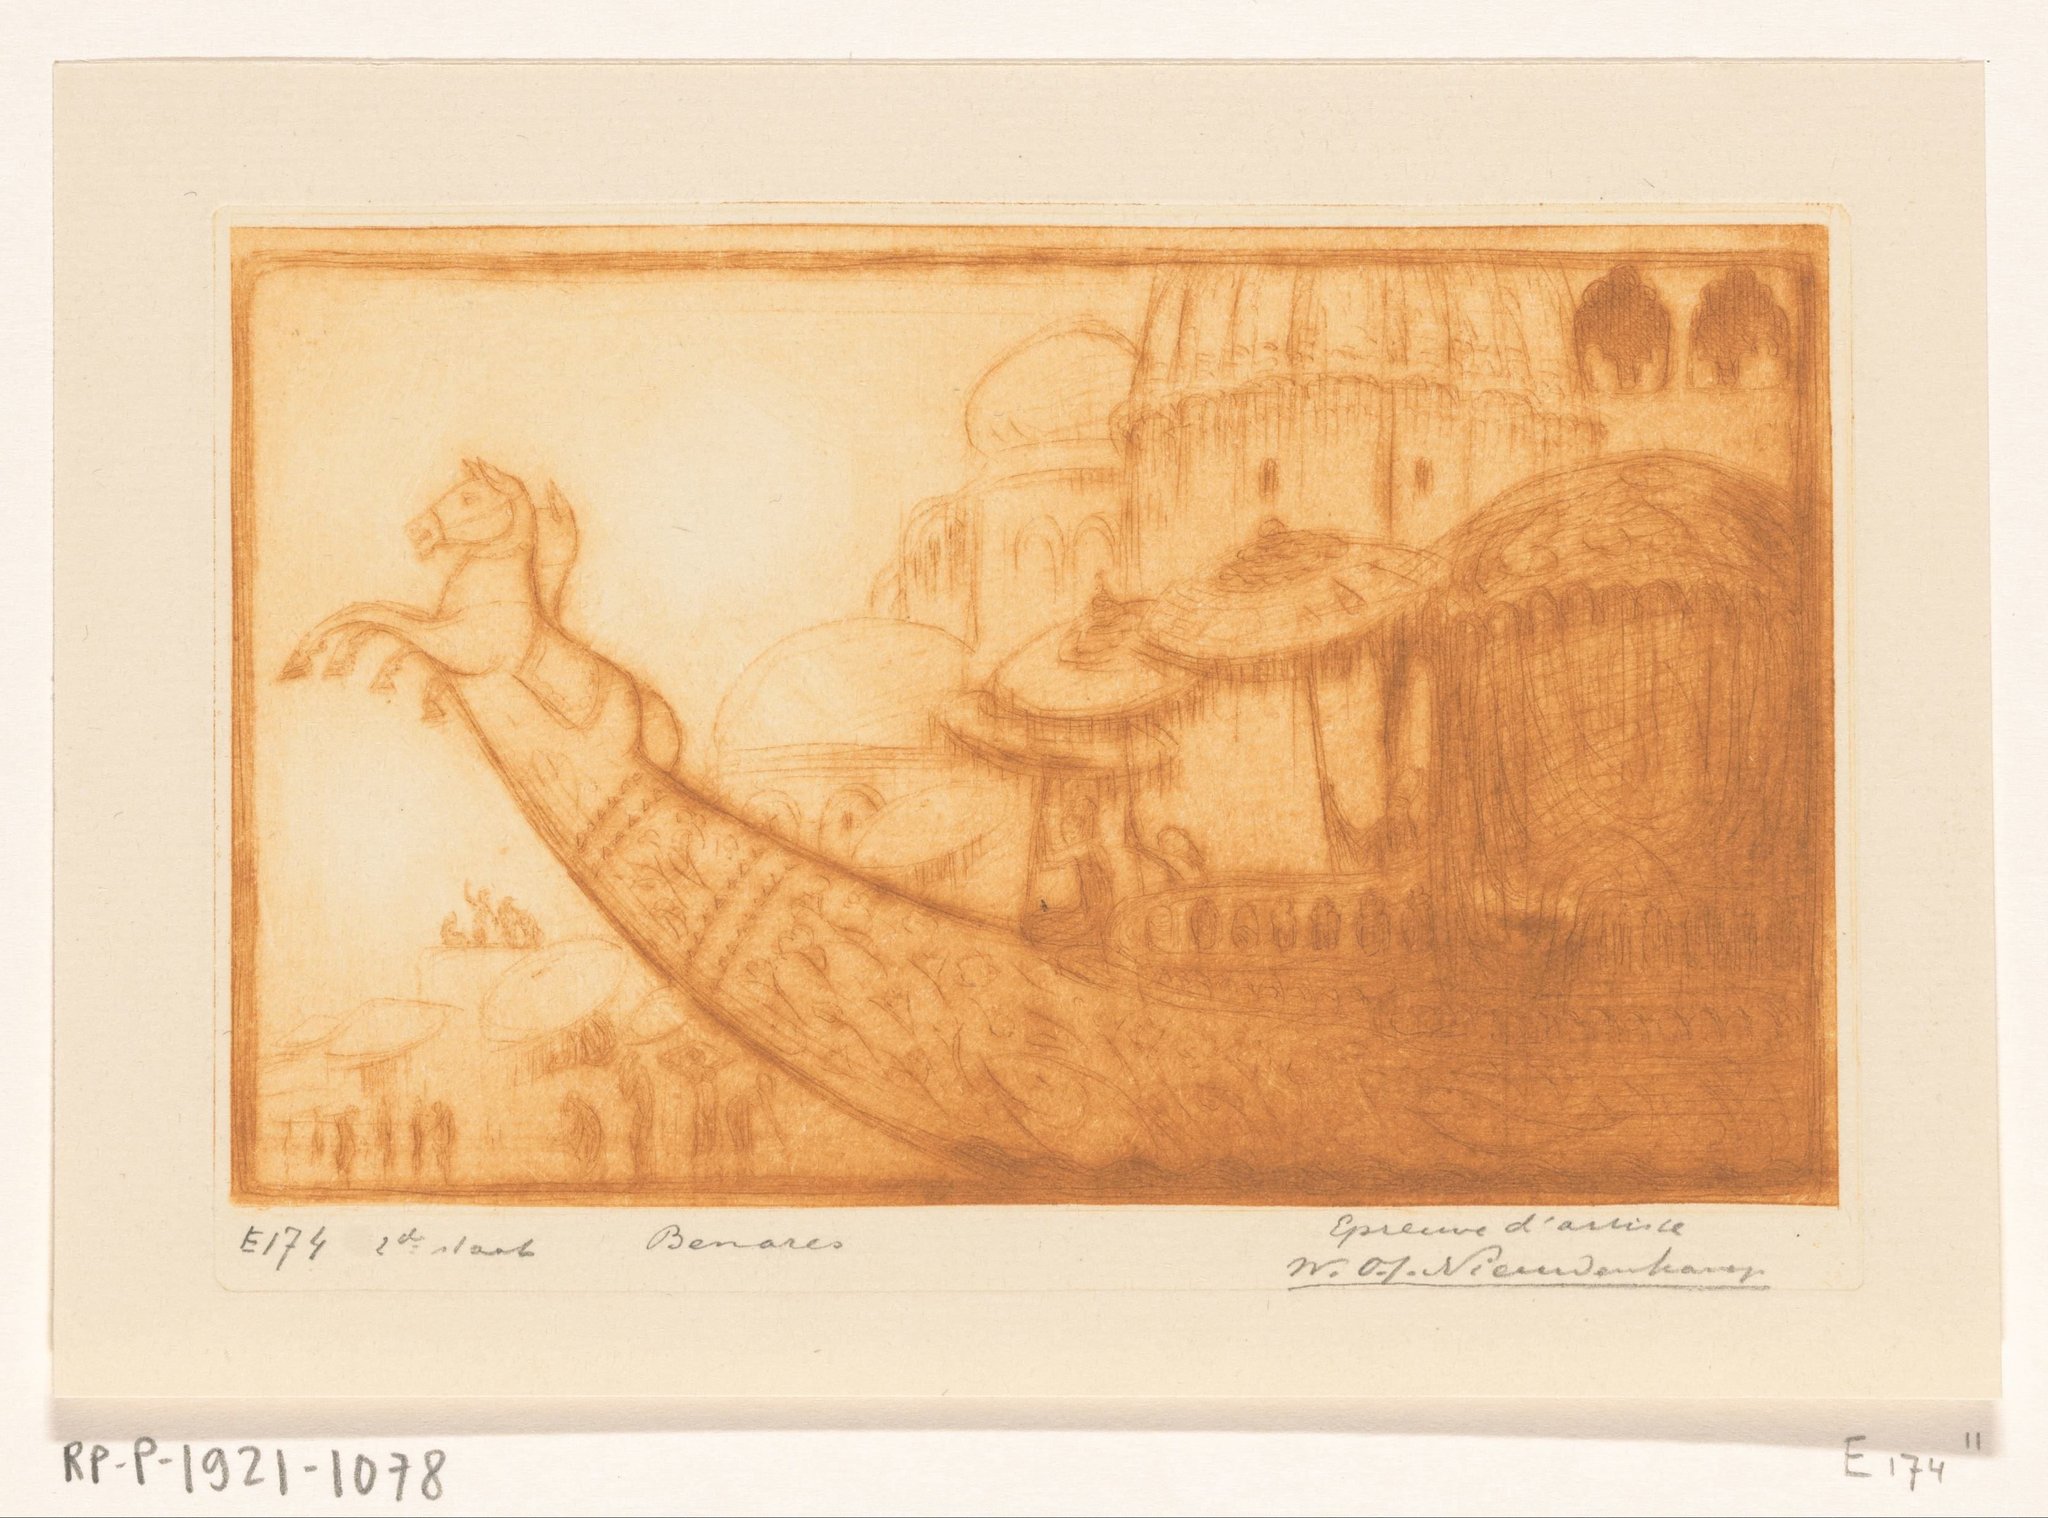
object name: print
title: Pleziervaartuig van de maharadja van Benares op de Ganges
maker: wijnand otto jan nieuwenkamp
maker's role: draughtsman, print maker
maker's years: 1874-1950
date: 1915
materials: paper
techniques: drypoint, intaglio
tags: places and objects of worship ~ hinduism, buddhism, jainism, ships (in general), horse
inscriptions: collector's mark: Lugt 2233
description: De voorsteven van het schip is met twee steigerende paarden versierd. Op de achtergrond enkele tempels.